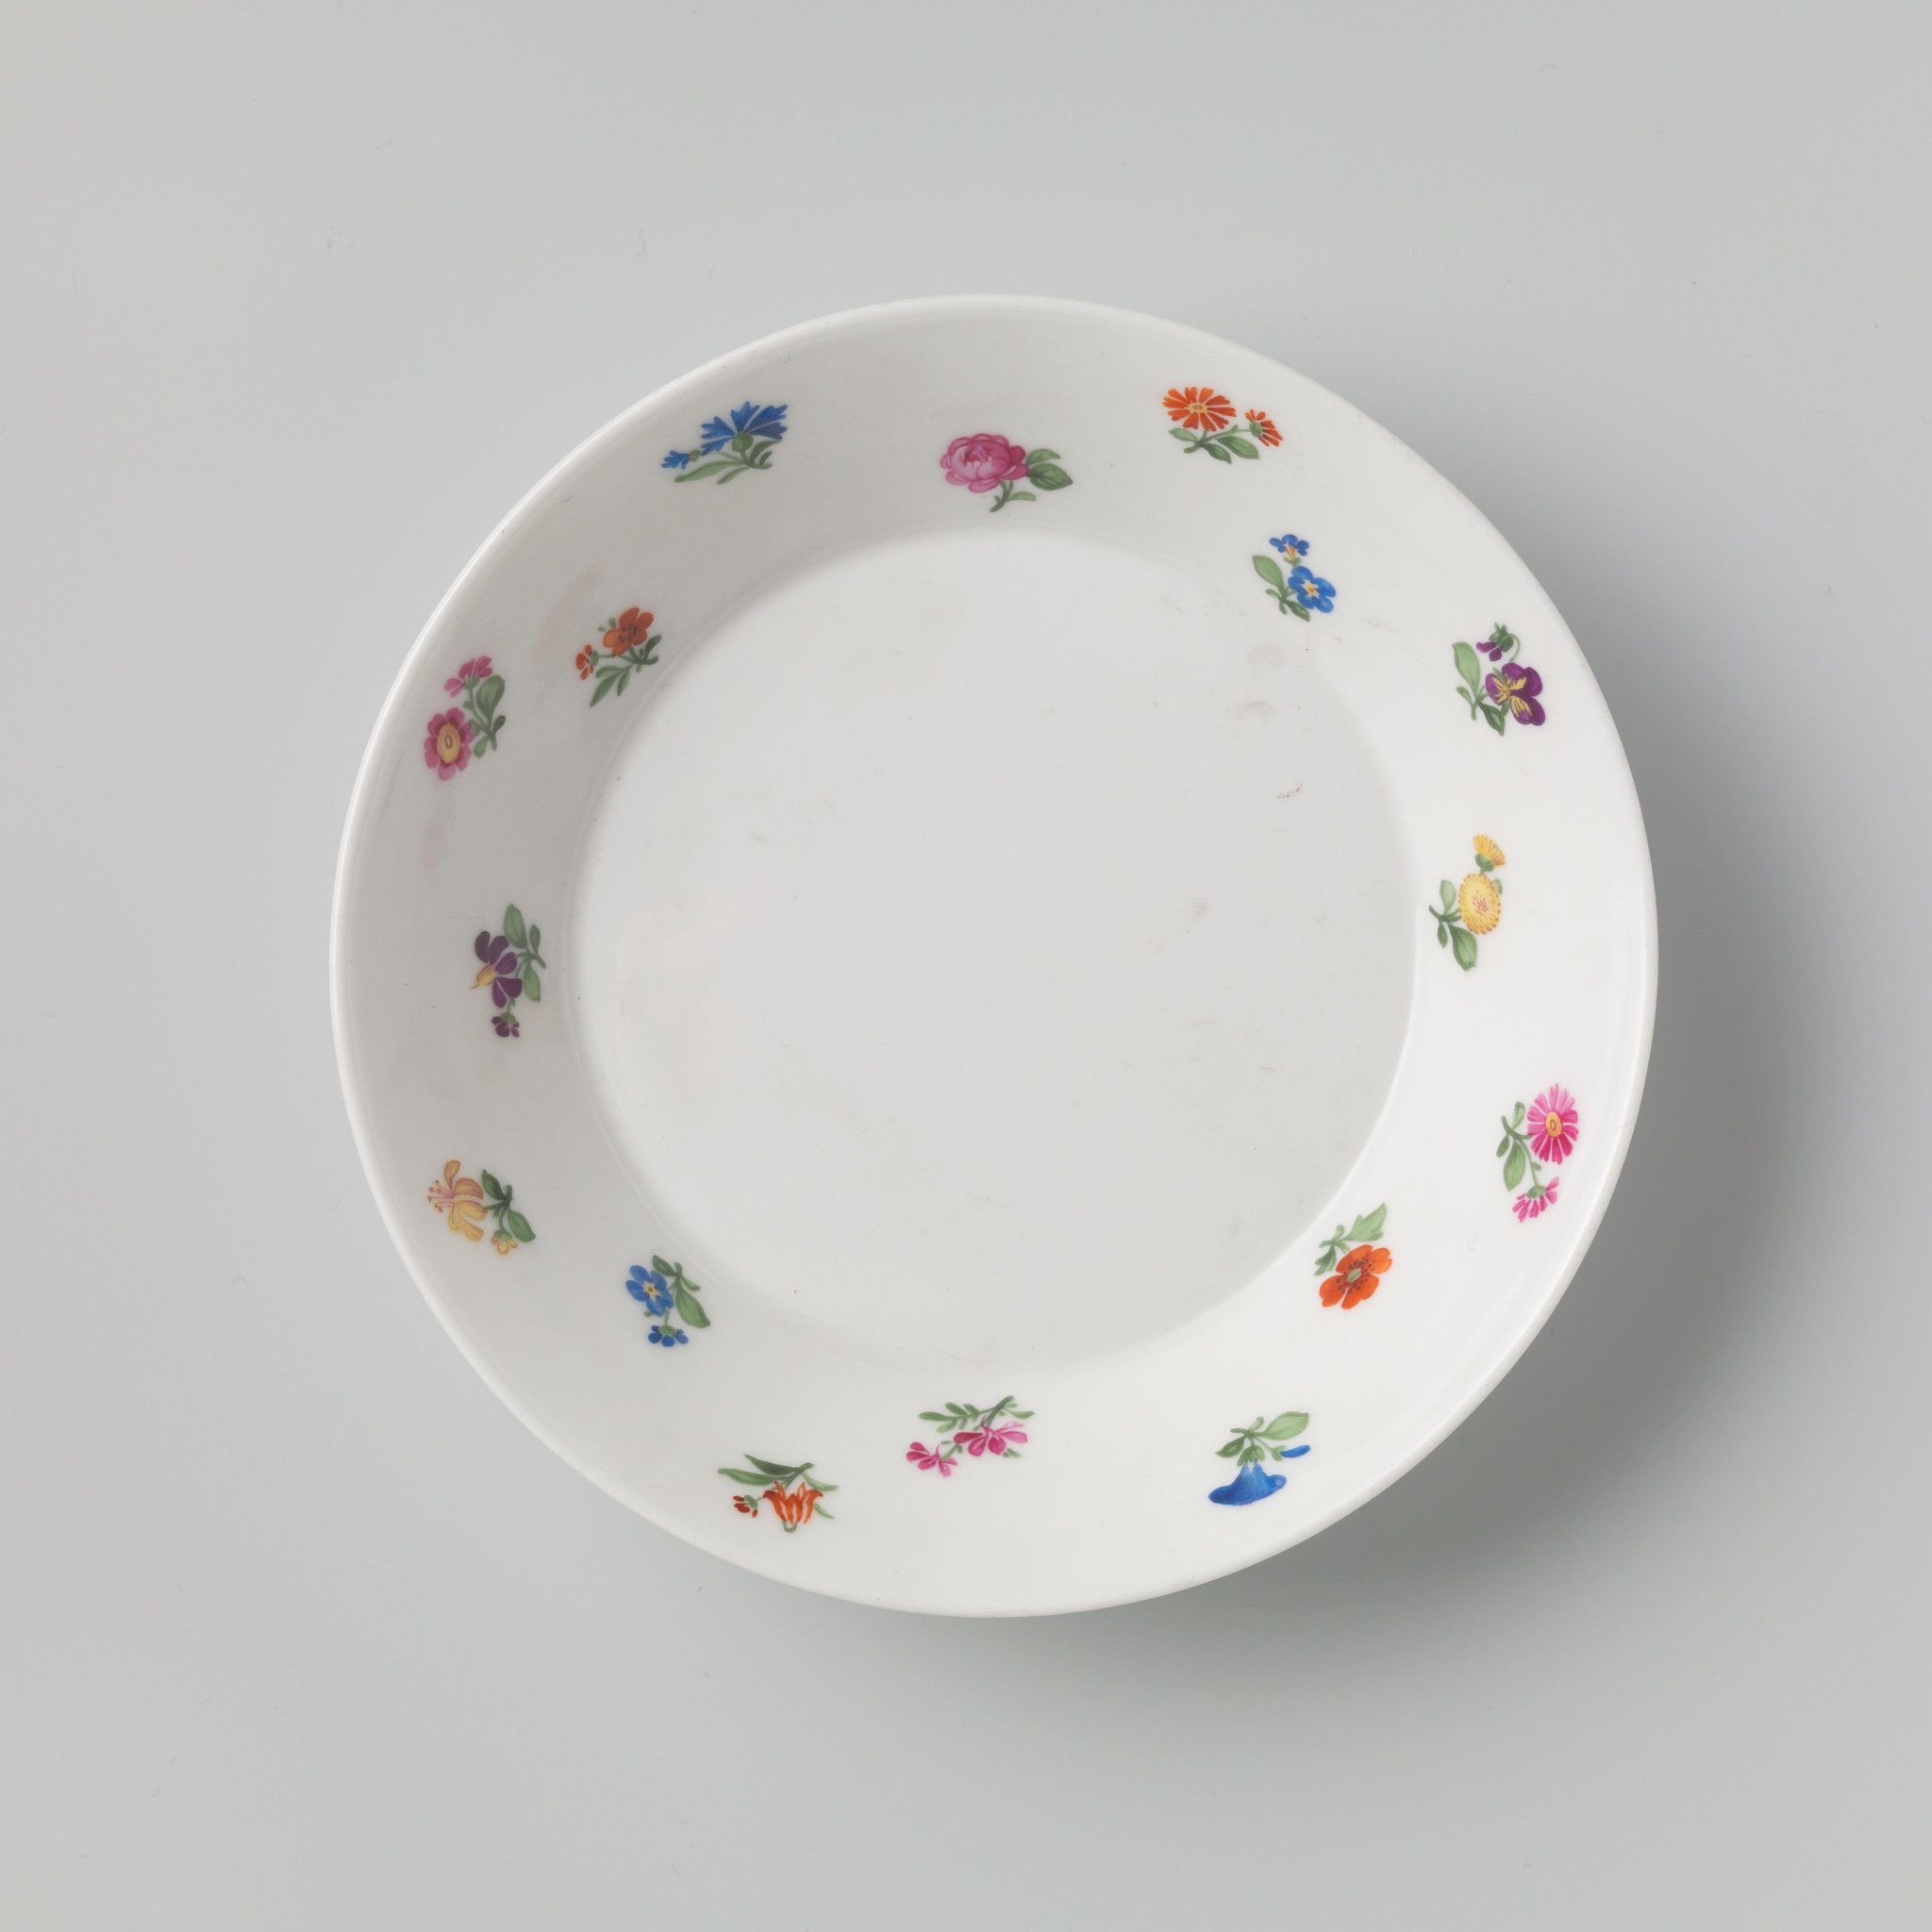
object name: platter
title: Saucer with flowers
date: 1837-1844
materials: glaze, paint, porcelain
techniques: firing, turning, vitrification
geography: berlin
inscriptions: mark: ‘scepter met K.P.M./ rode rijksappel met K.P.M/ 26/ II’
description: Schotel van porselein, beschilderd op het glazuur in blauw, rood, roze, groen, geel, paars en zwart. De binnenwand is bedekt met kleine strooibloemen. De achterzijde is ongedecoreerd. Gemerkt op de onderzijde met de scepter met K.P.M., de rode rijksappel met K.P.M, het nummer 26 en II.